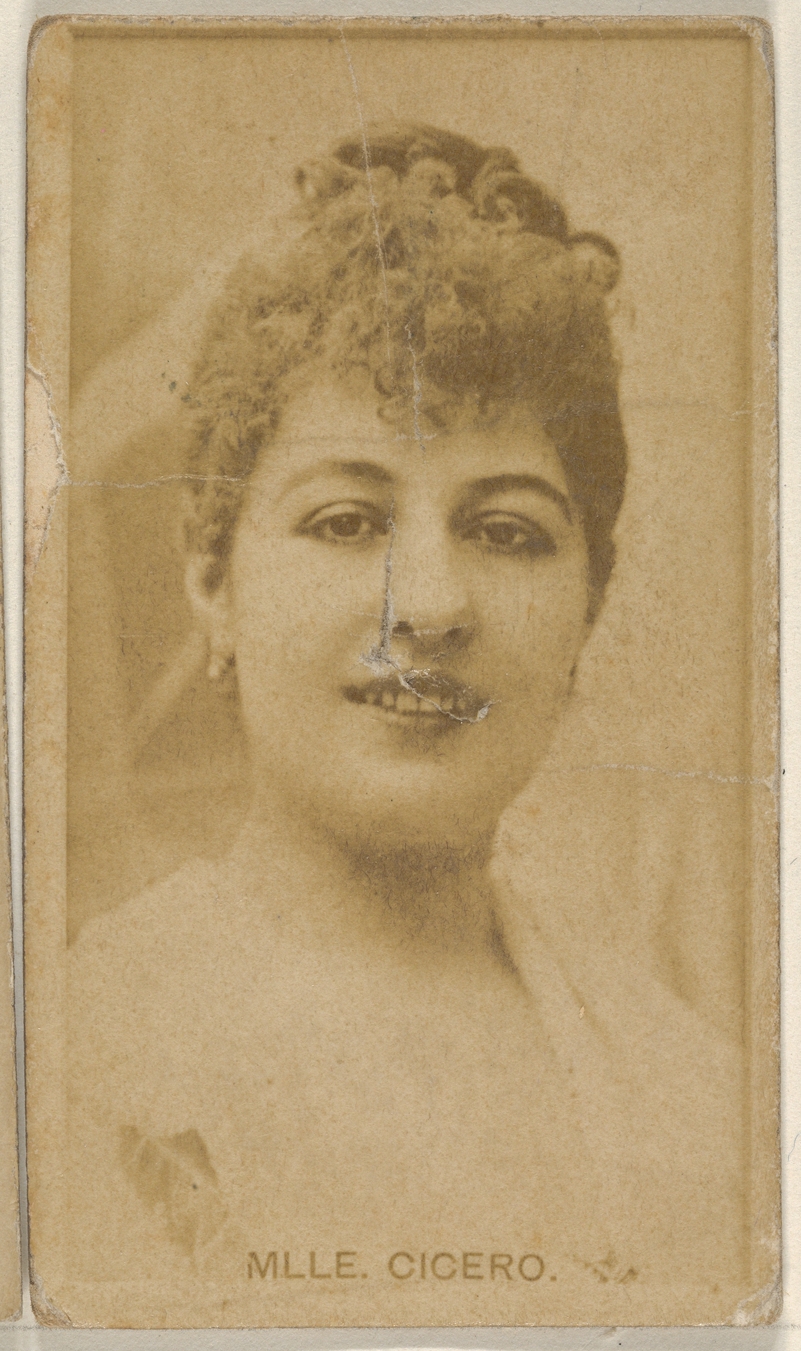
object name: photograph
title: Mlle. Cicero, from the Actors and Actresses series (N45, Type 8) for Virginia Brights Cigarettes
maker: allen & ginter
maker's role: publisher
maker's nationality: american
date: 1888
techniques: albumen silver print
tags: portraits,women,actresses